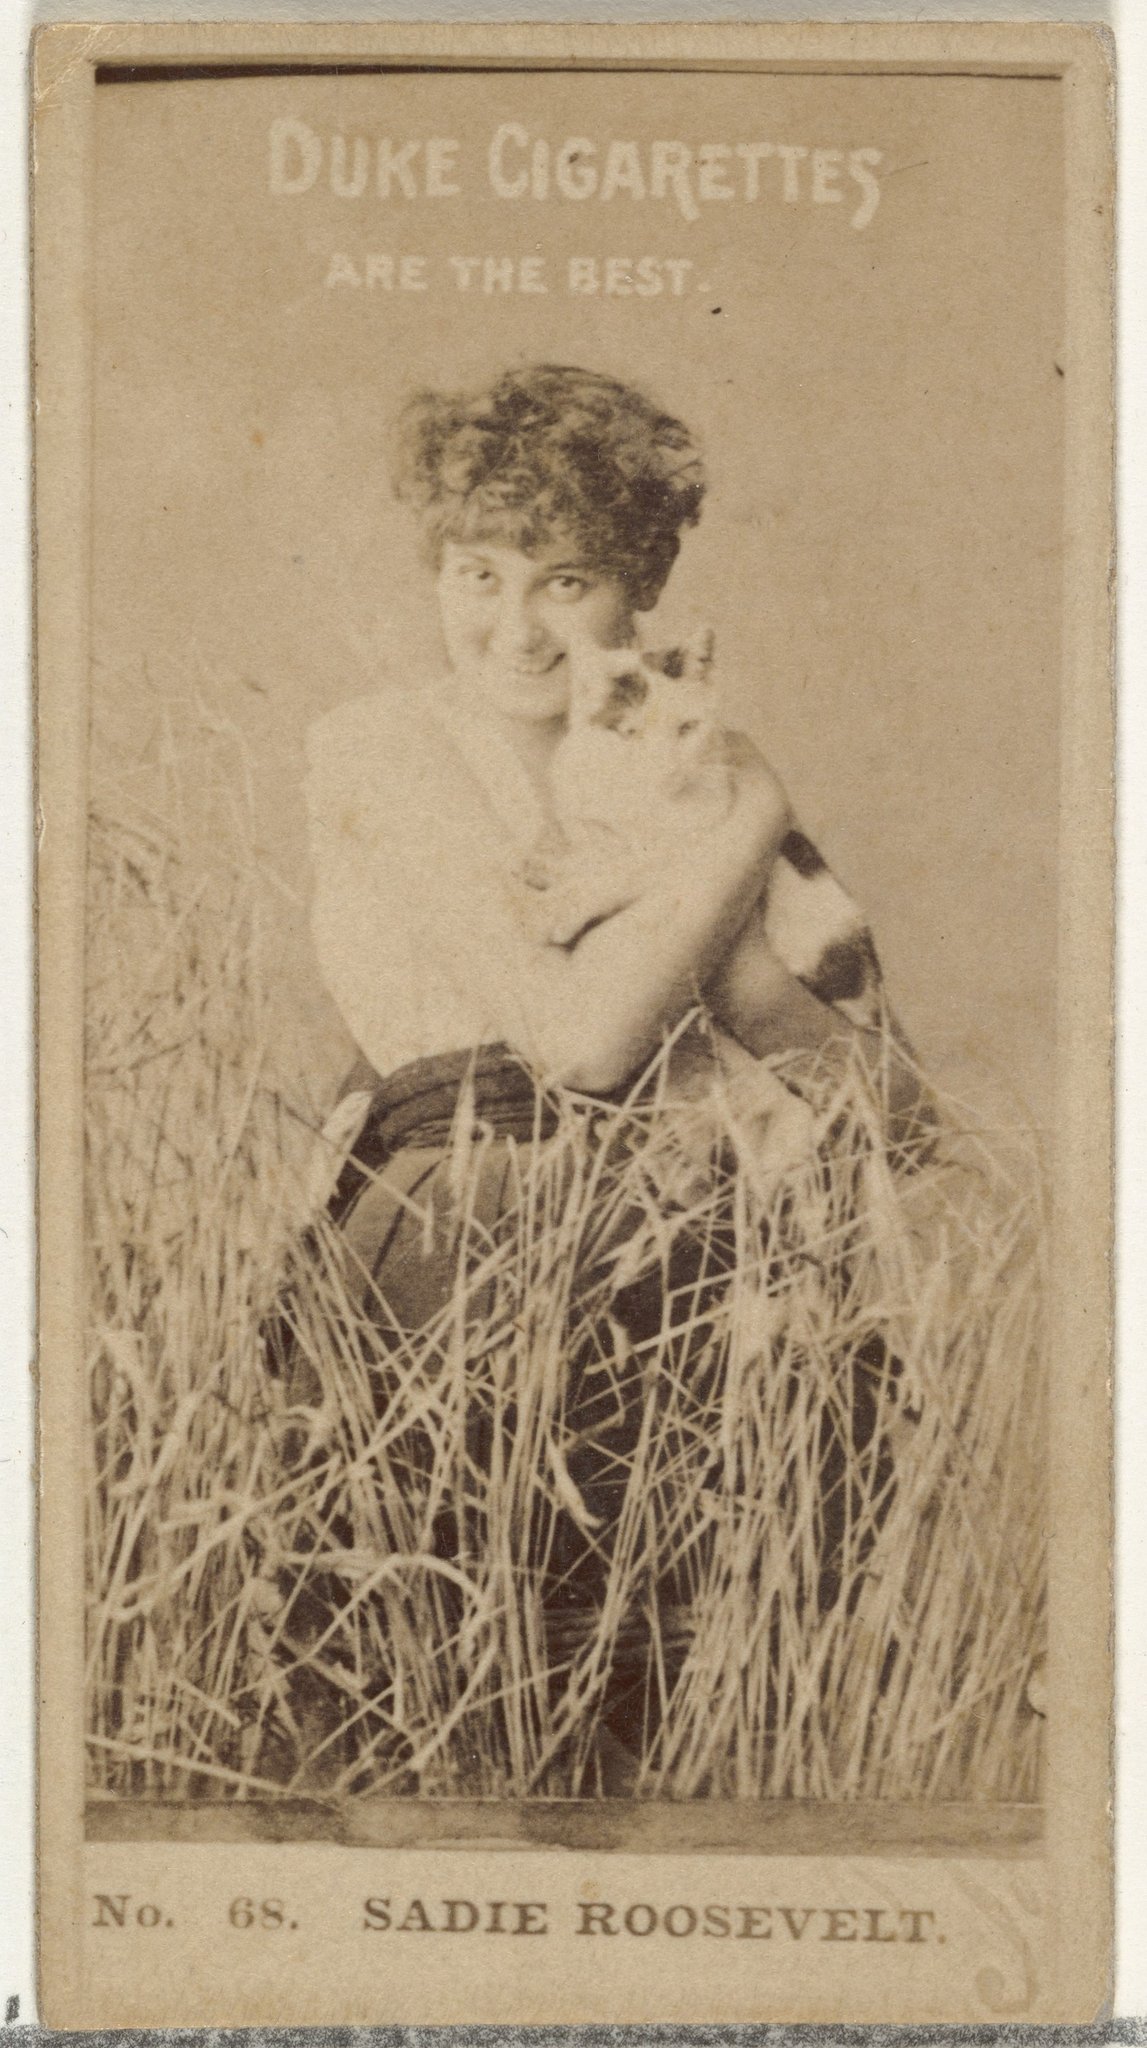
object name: photograph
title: Card Number 68, Sadie Roosevelt, from the Actors and Actresses series (N145-6) issued by Duke Sons & Co. to promote Duke Cigarettes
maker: w. duke, sons & co.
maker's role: publisher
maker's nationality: american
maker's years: 1870-1920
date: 1880-1889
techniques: albumen silver print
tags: portraits,women,cats,actresses